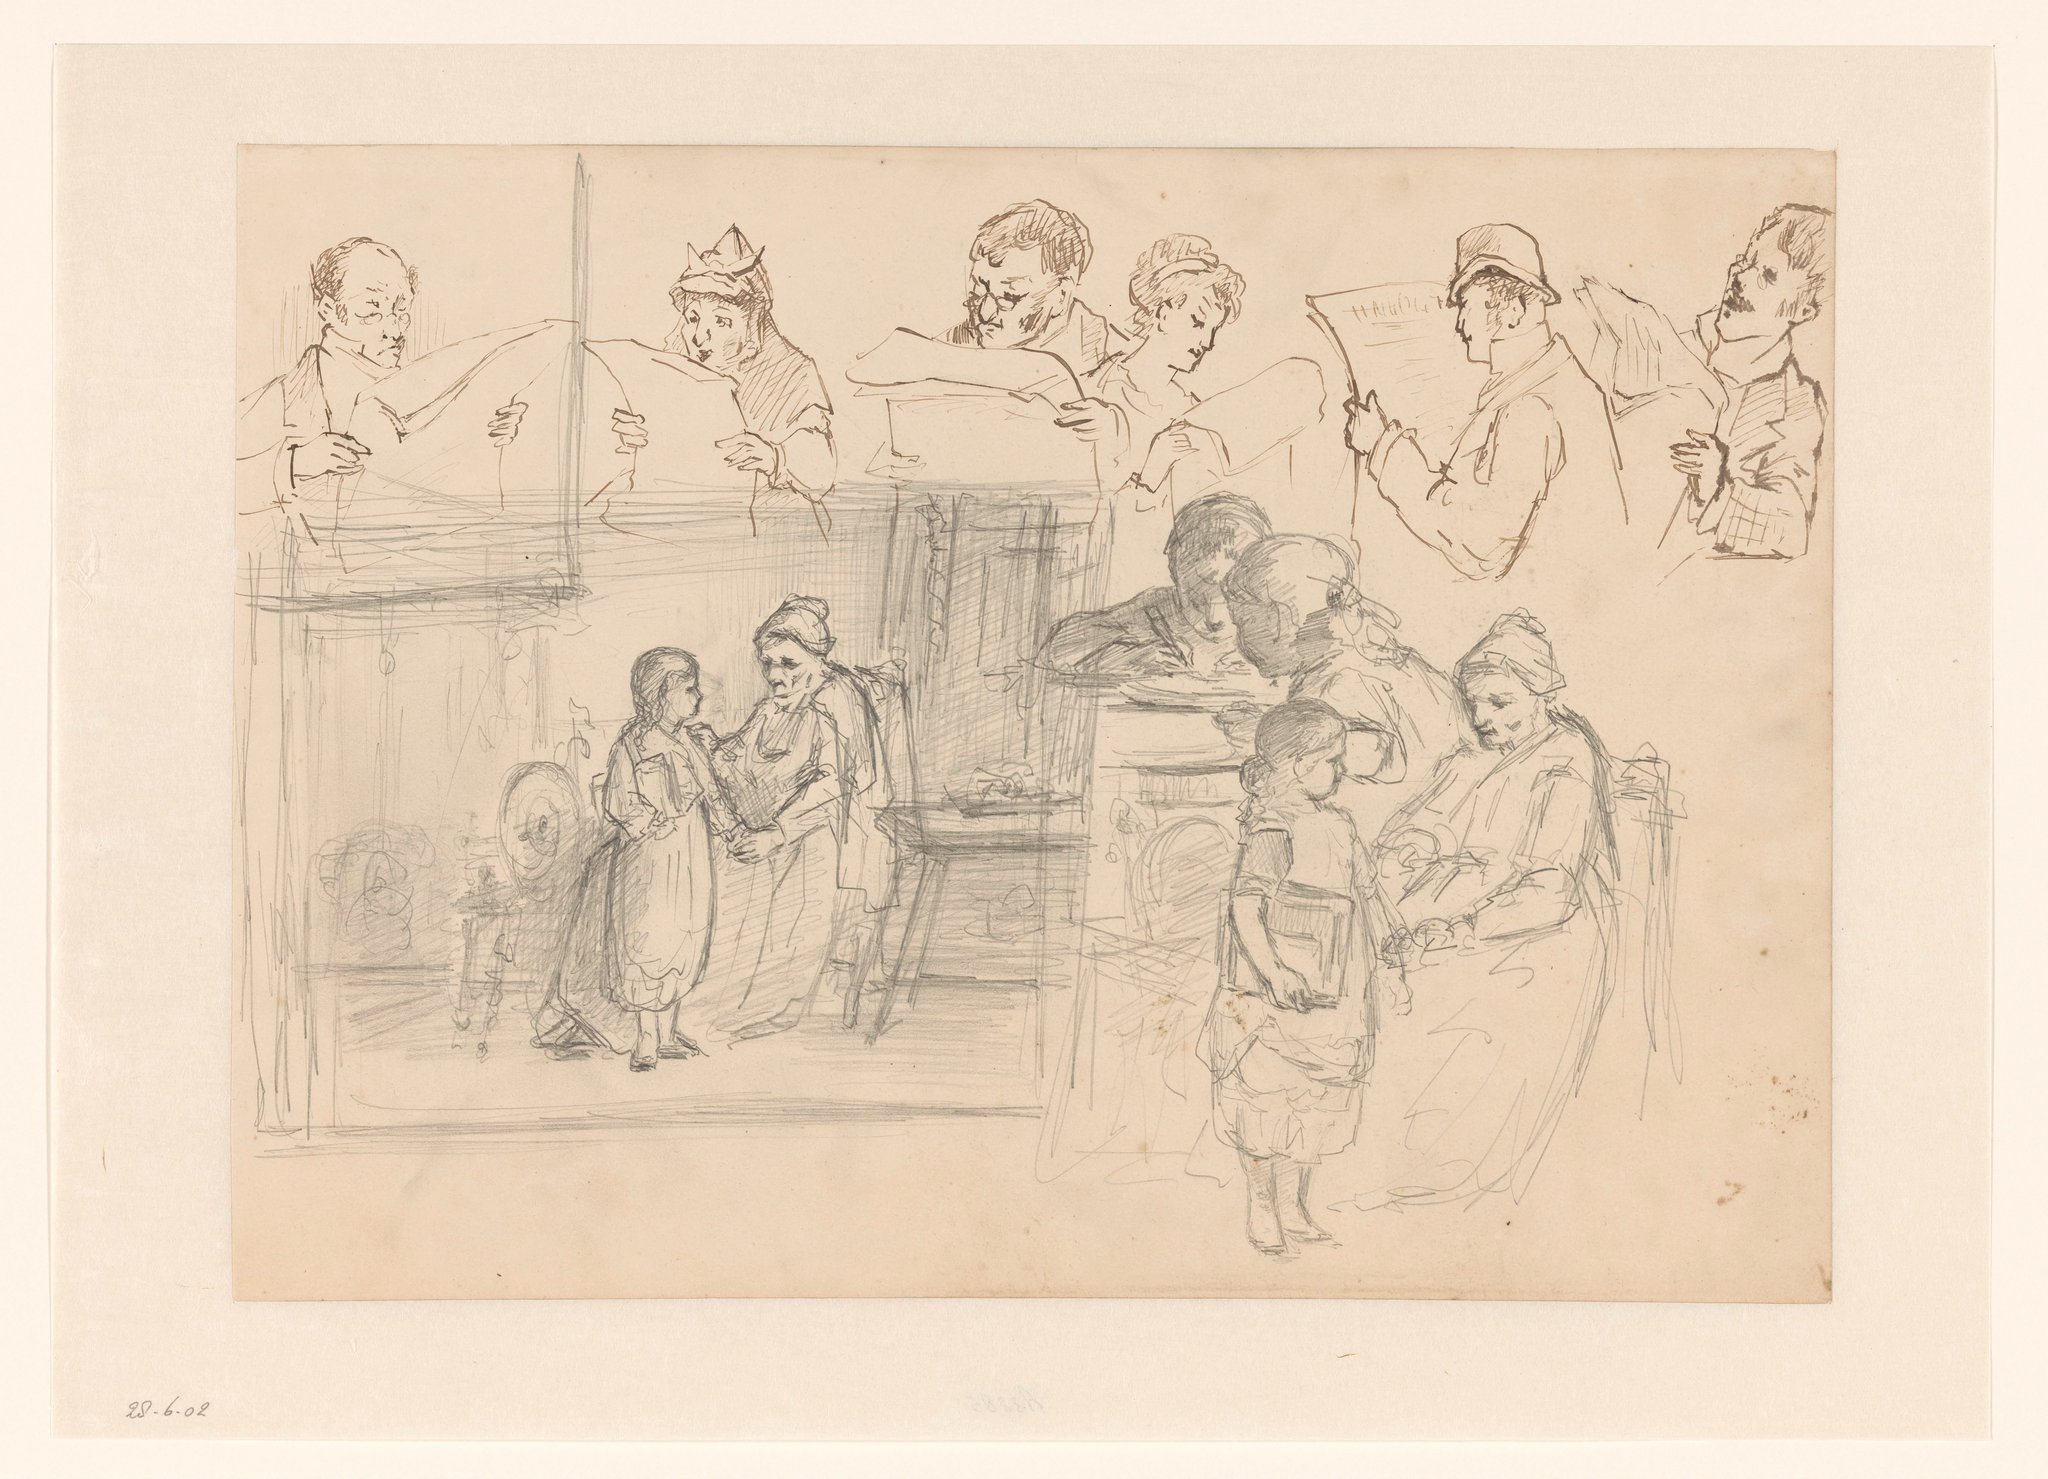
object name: drawing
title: Krantenlezers, kind met oude vrouw in interieur en schrijvende kinderen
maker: hendrik valkenburg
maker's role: draughtsman, painter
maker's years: 1826-1896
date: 1836-1896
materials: chalk, ink, paper, pencil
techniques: pen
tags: interior of the house, mother and child(ren), woman and child(ren) (family group)